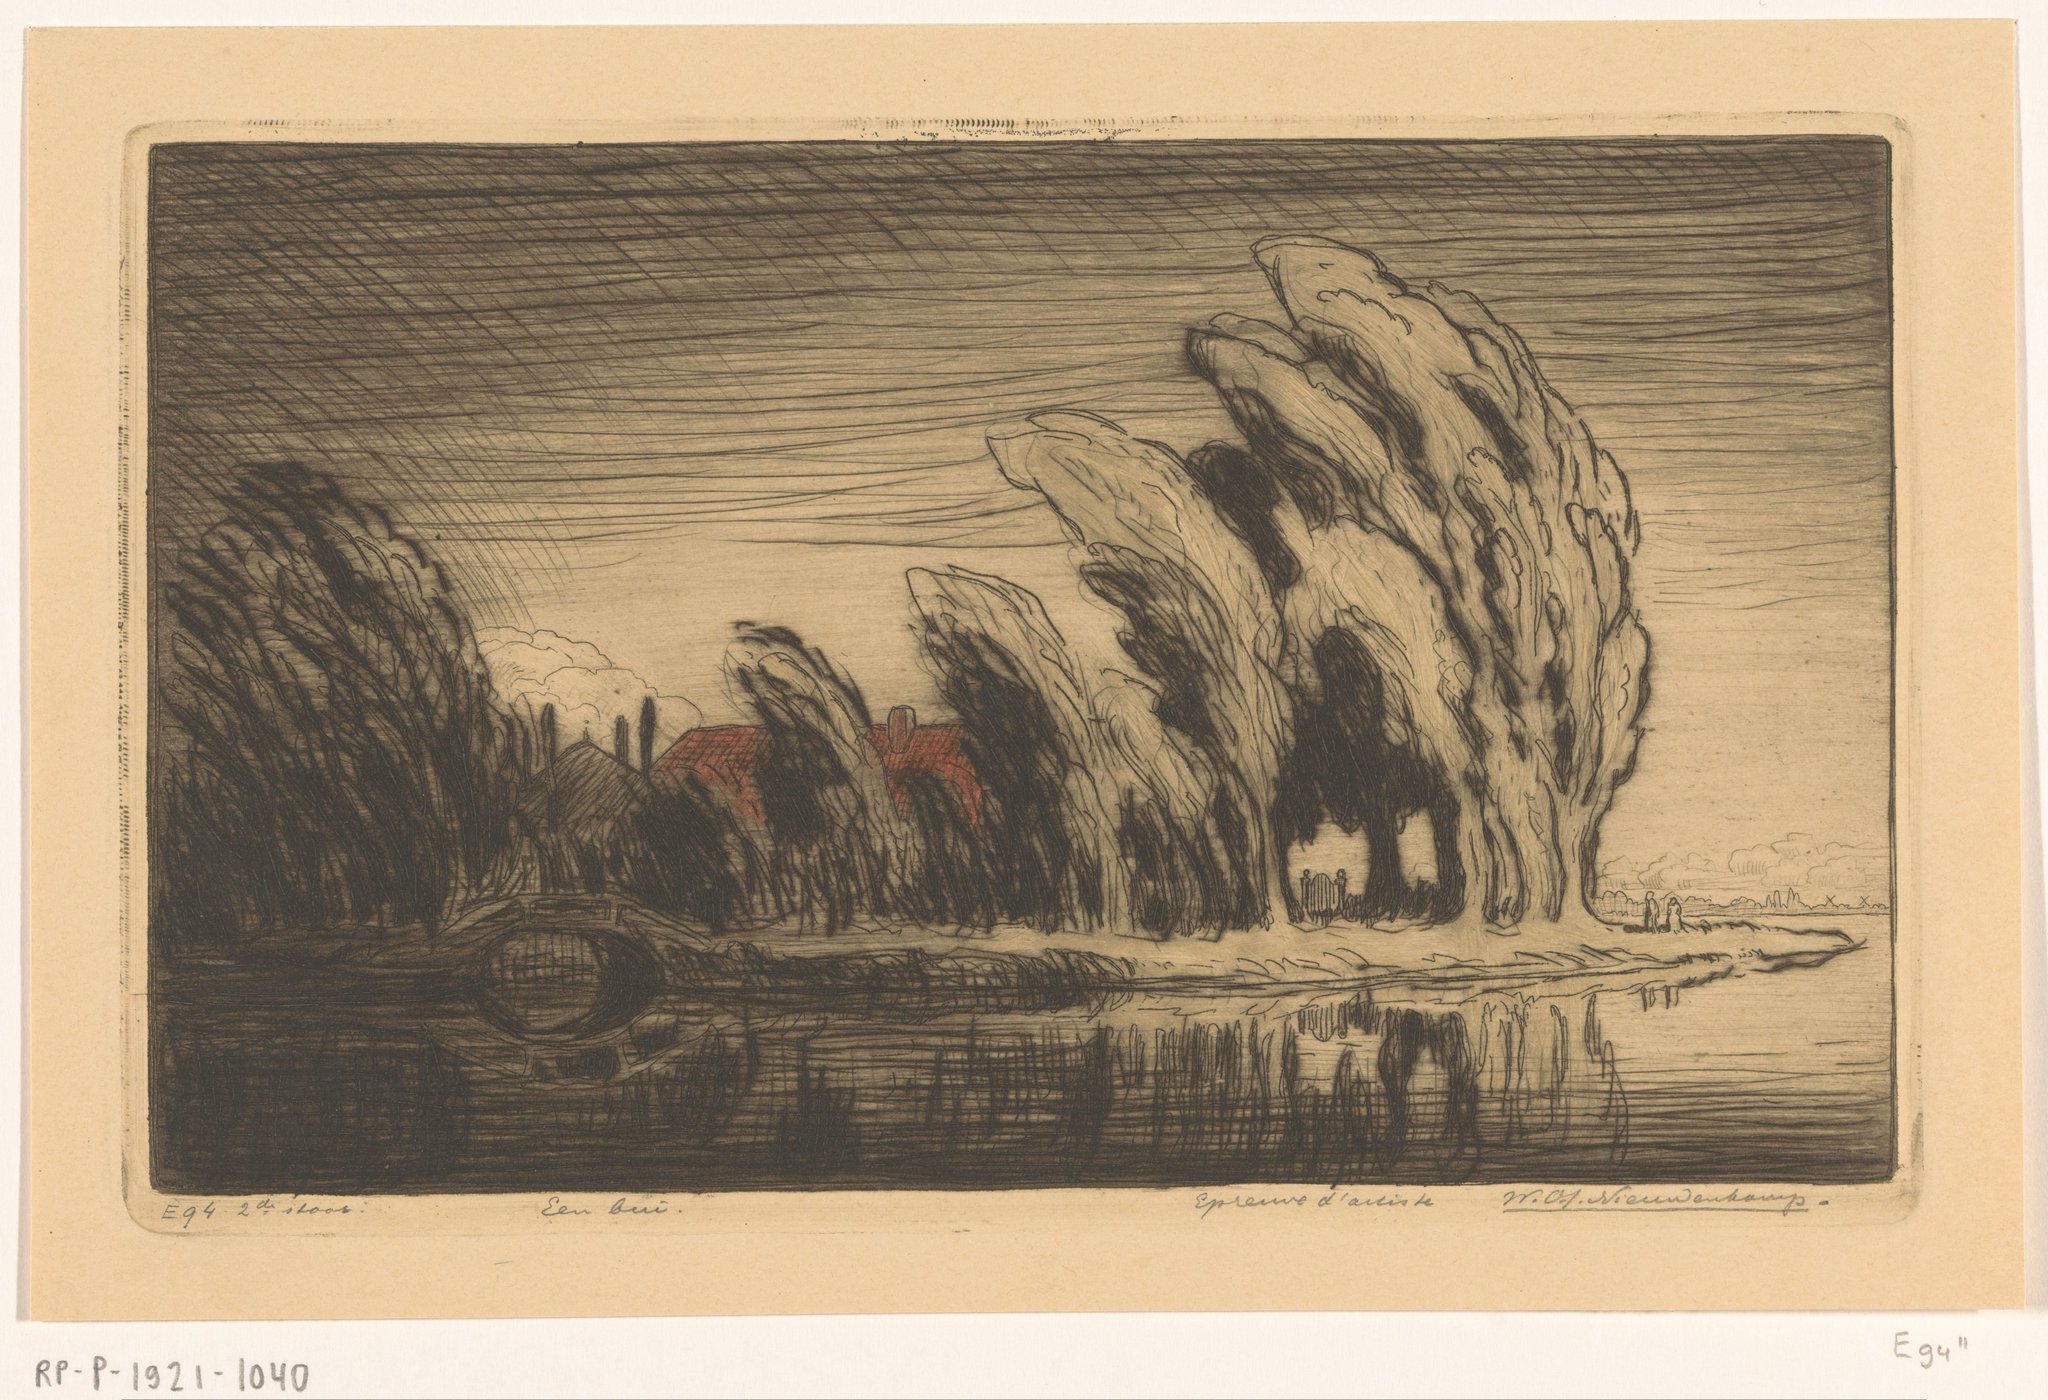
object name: print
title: Een bui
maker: wijnand otto jan nieuwenkamp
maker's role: draughtsman, print maker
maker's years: 1874-1950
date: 1907-1910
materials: paper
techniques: drypoint, intaglio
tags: trees, farm or solitary house in landscape, storm on land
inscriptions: collector's mark: Lugt 2233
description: Links een brug. Rechts bomen die buigen door de wind.